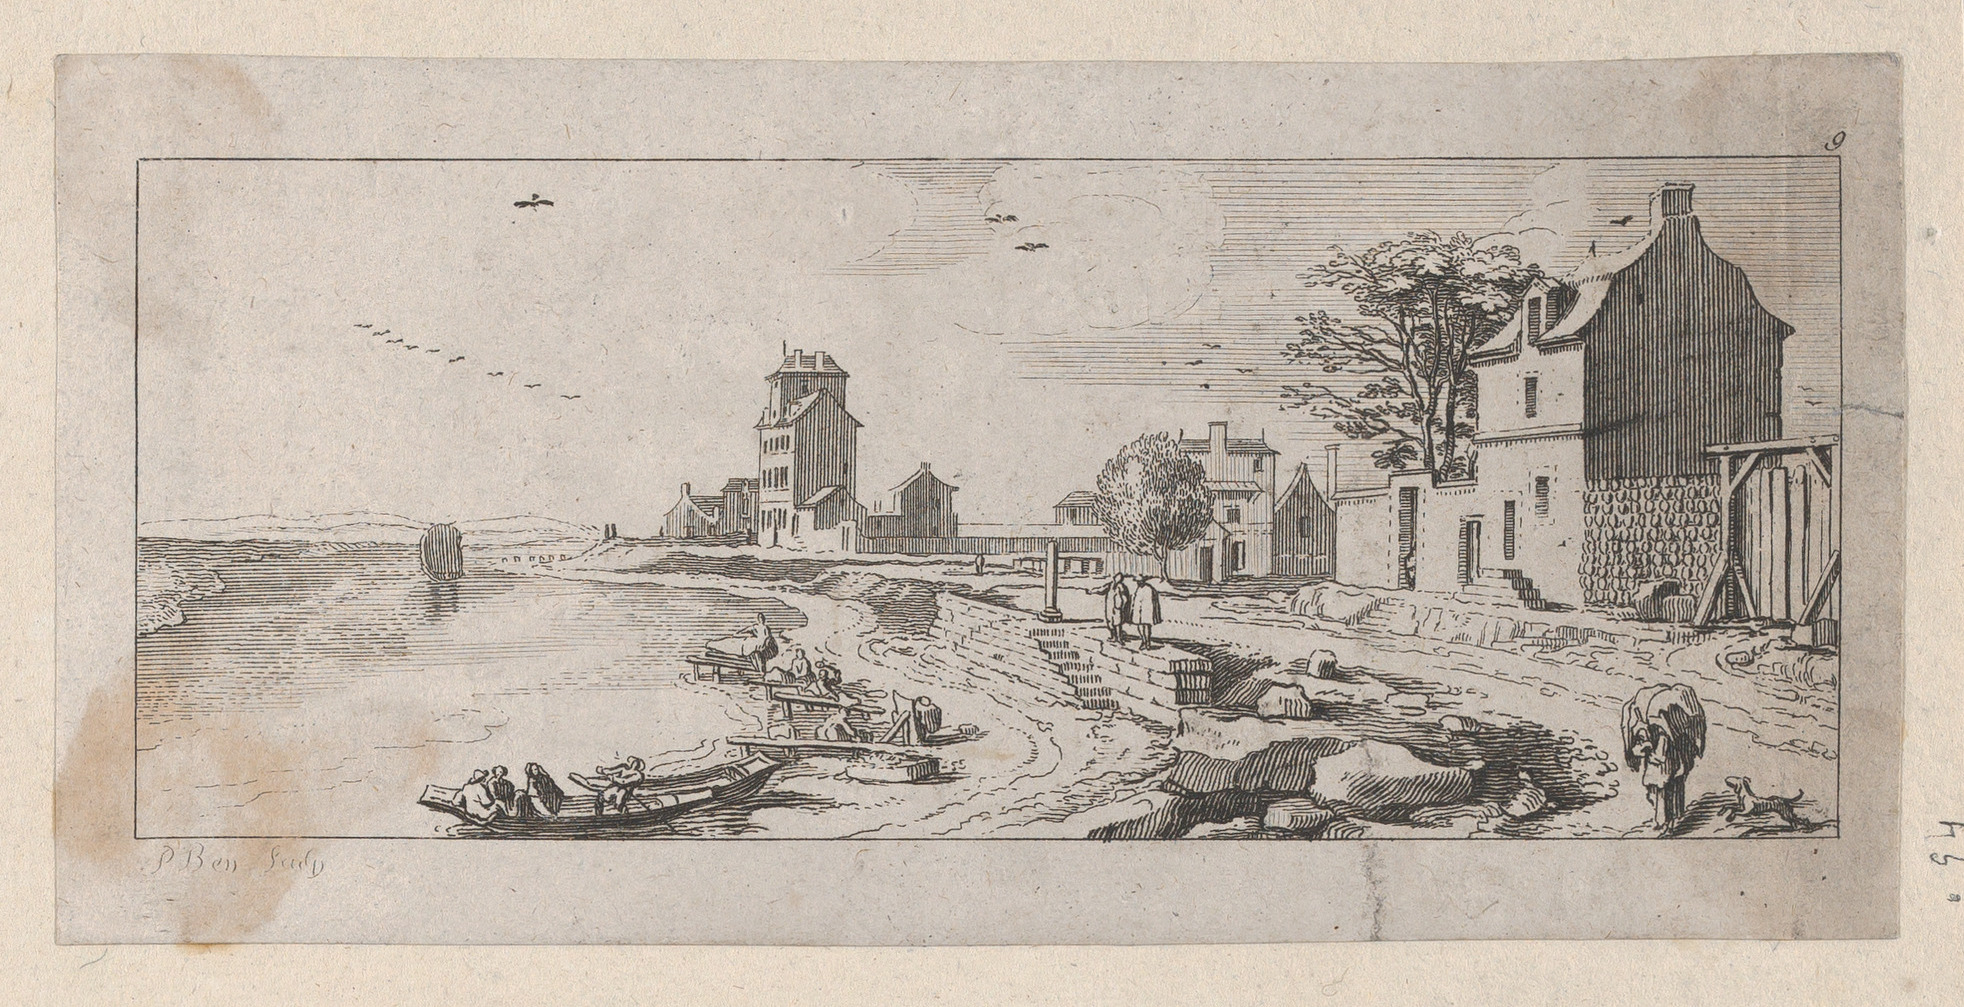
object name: print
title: View of a Natural Port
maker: antoine benoist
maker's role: artist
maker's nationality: french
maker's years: 1721-1770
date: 1736-1770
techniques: engraving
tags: docks,boats